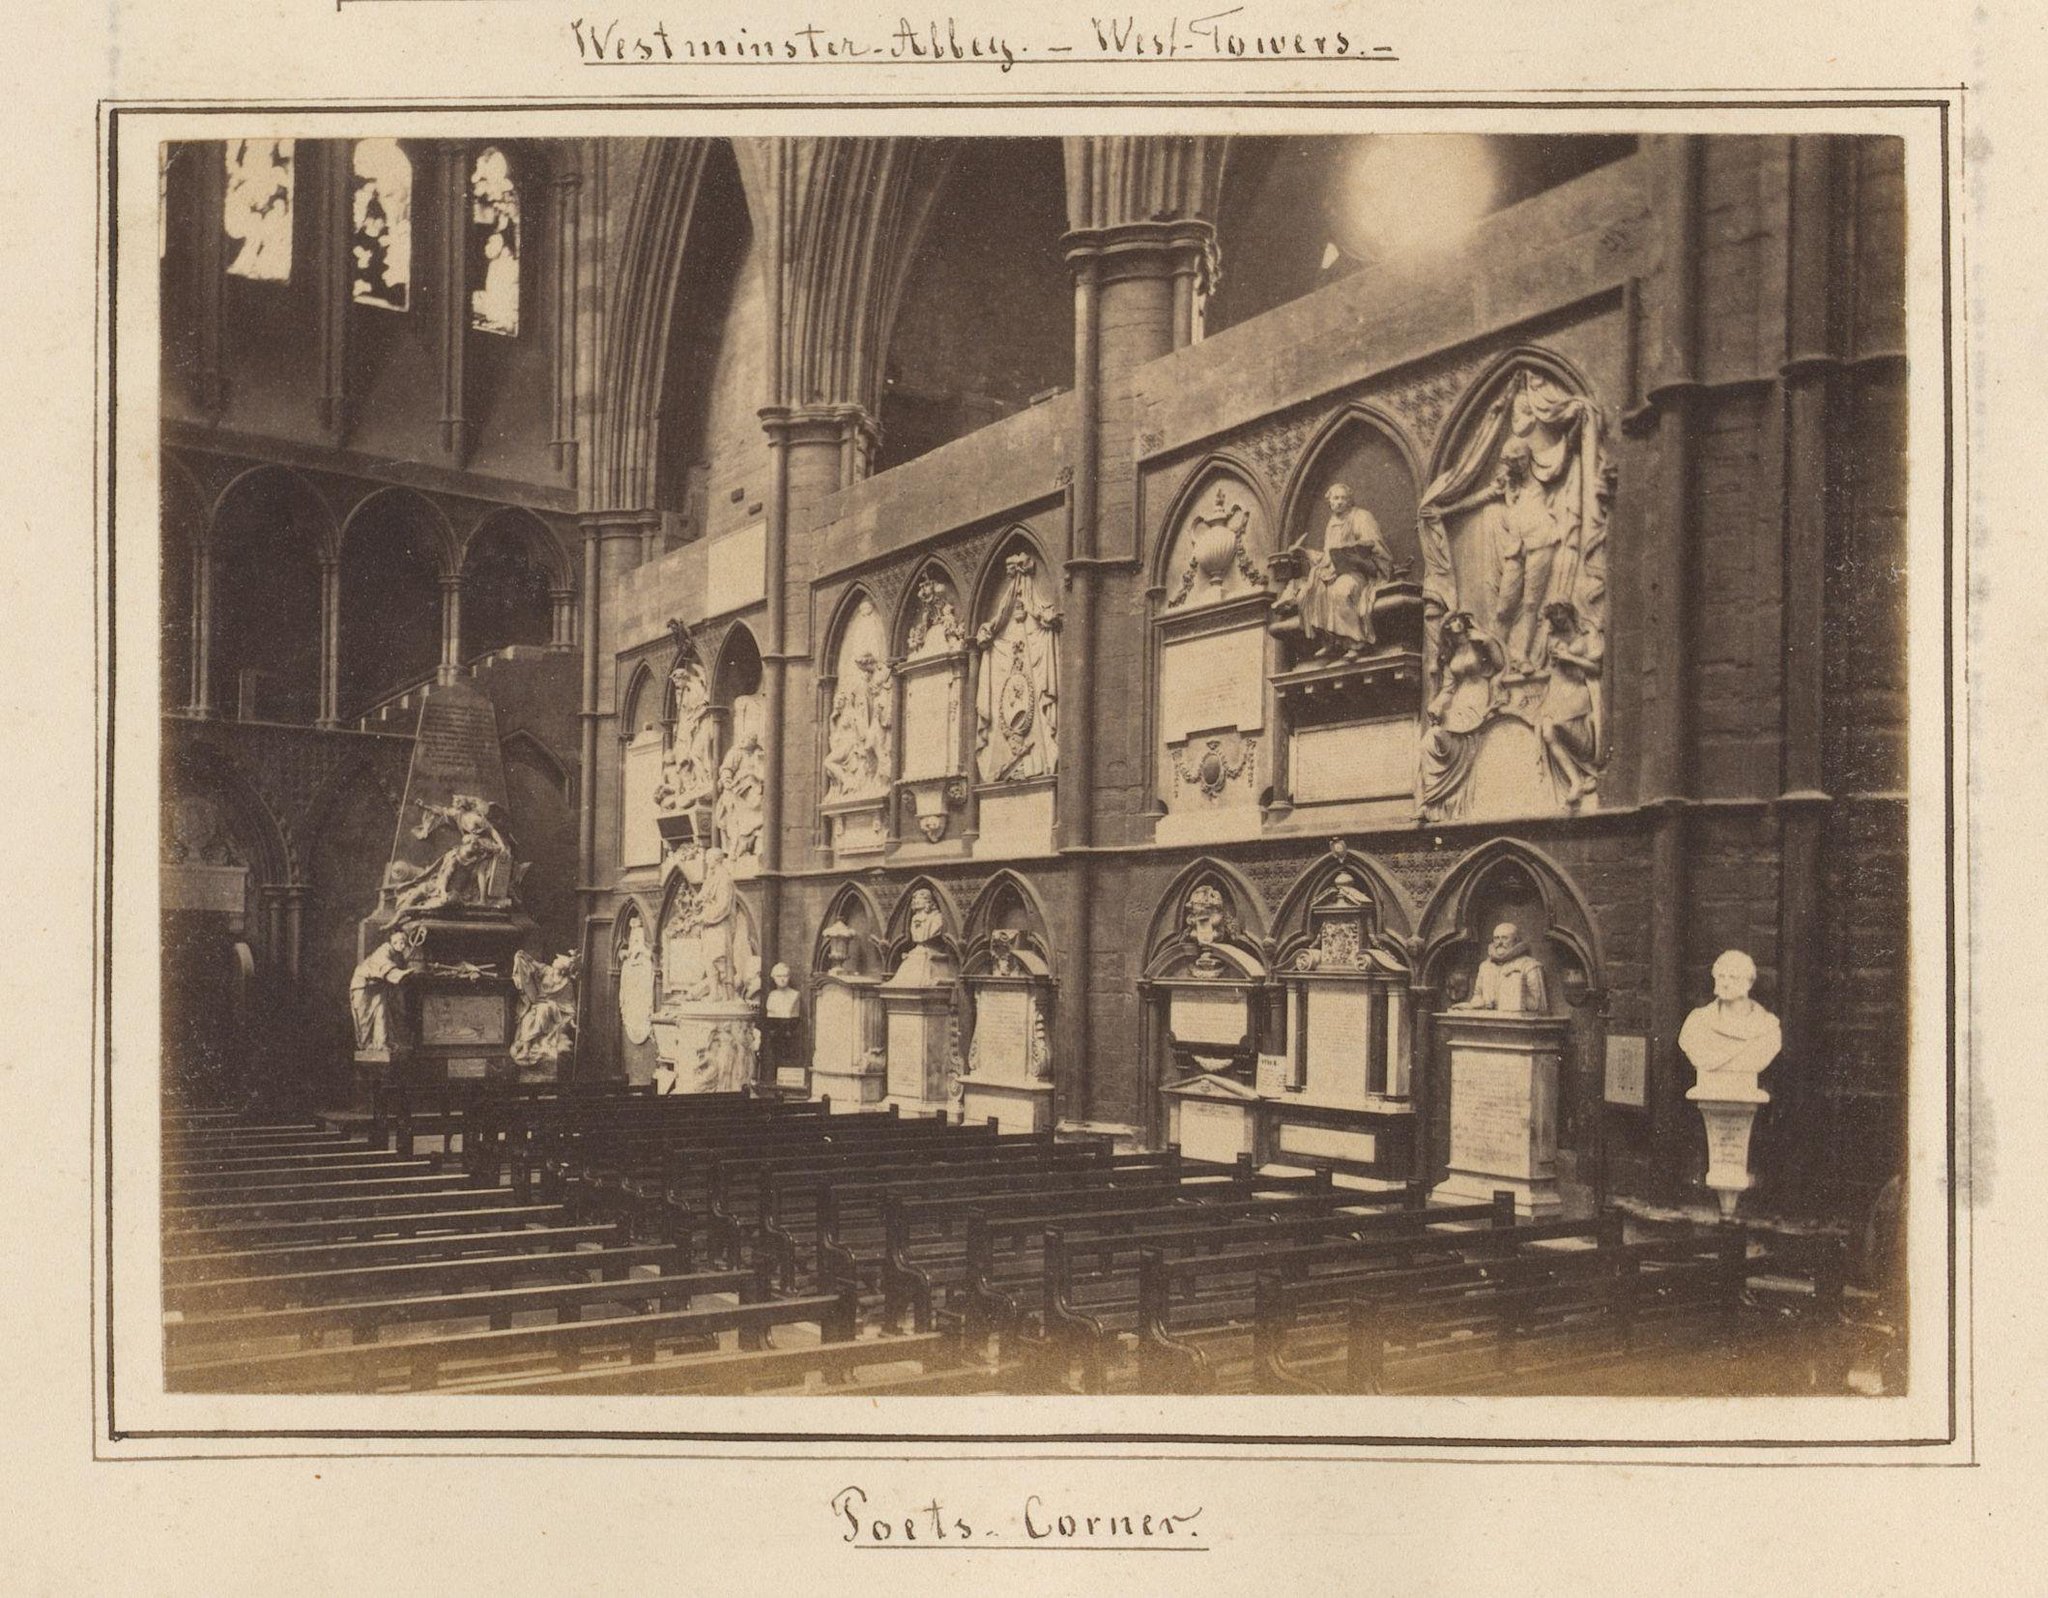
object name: album leaf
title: Poets Corner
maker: Anonymous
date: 1870-1890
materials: paper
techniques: albumen print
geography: london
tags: other memorial structures, westminster abbey